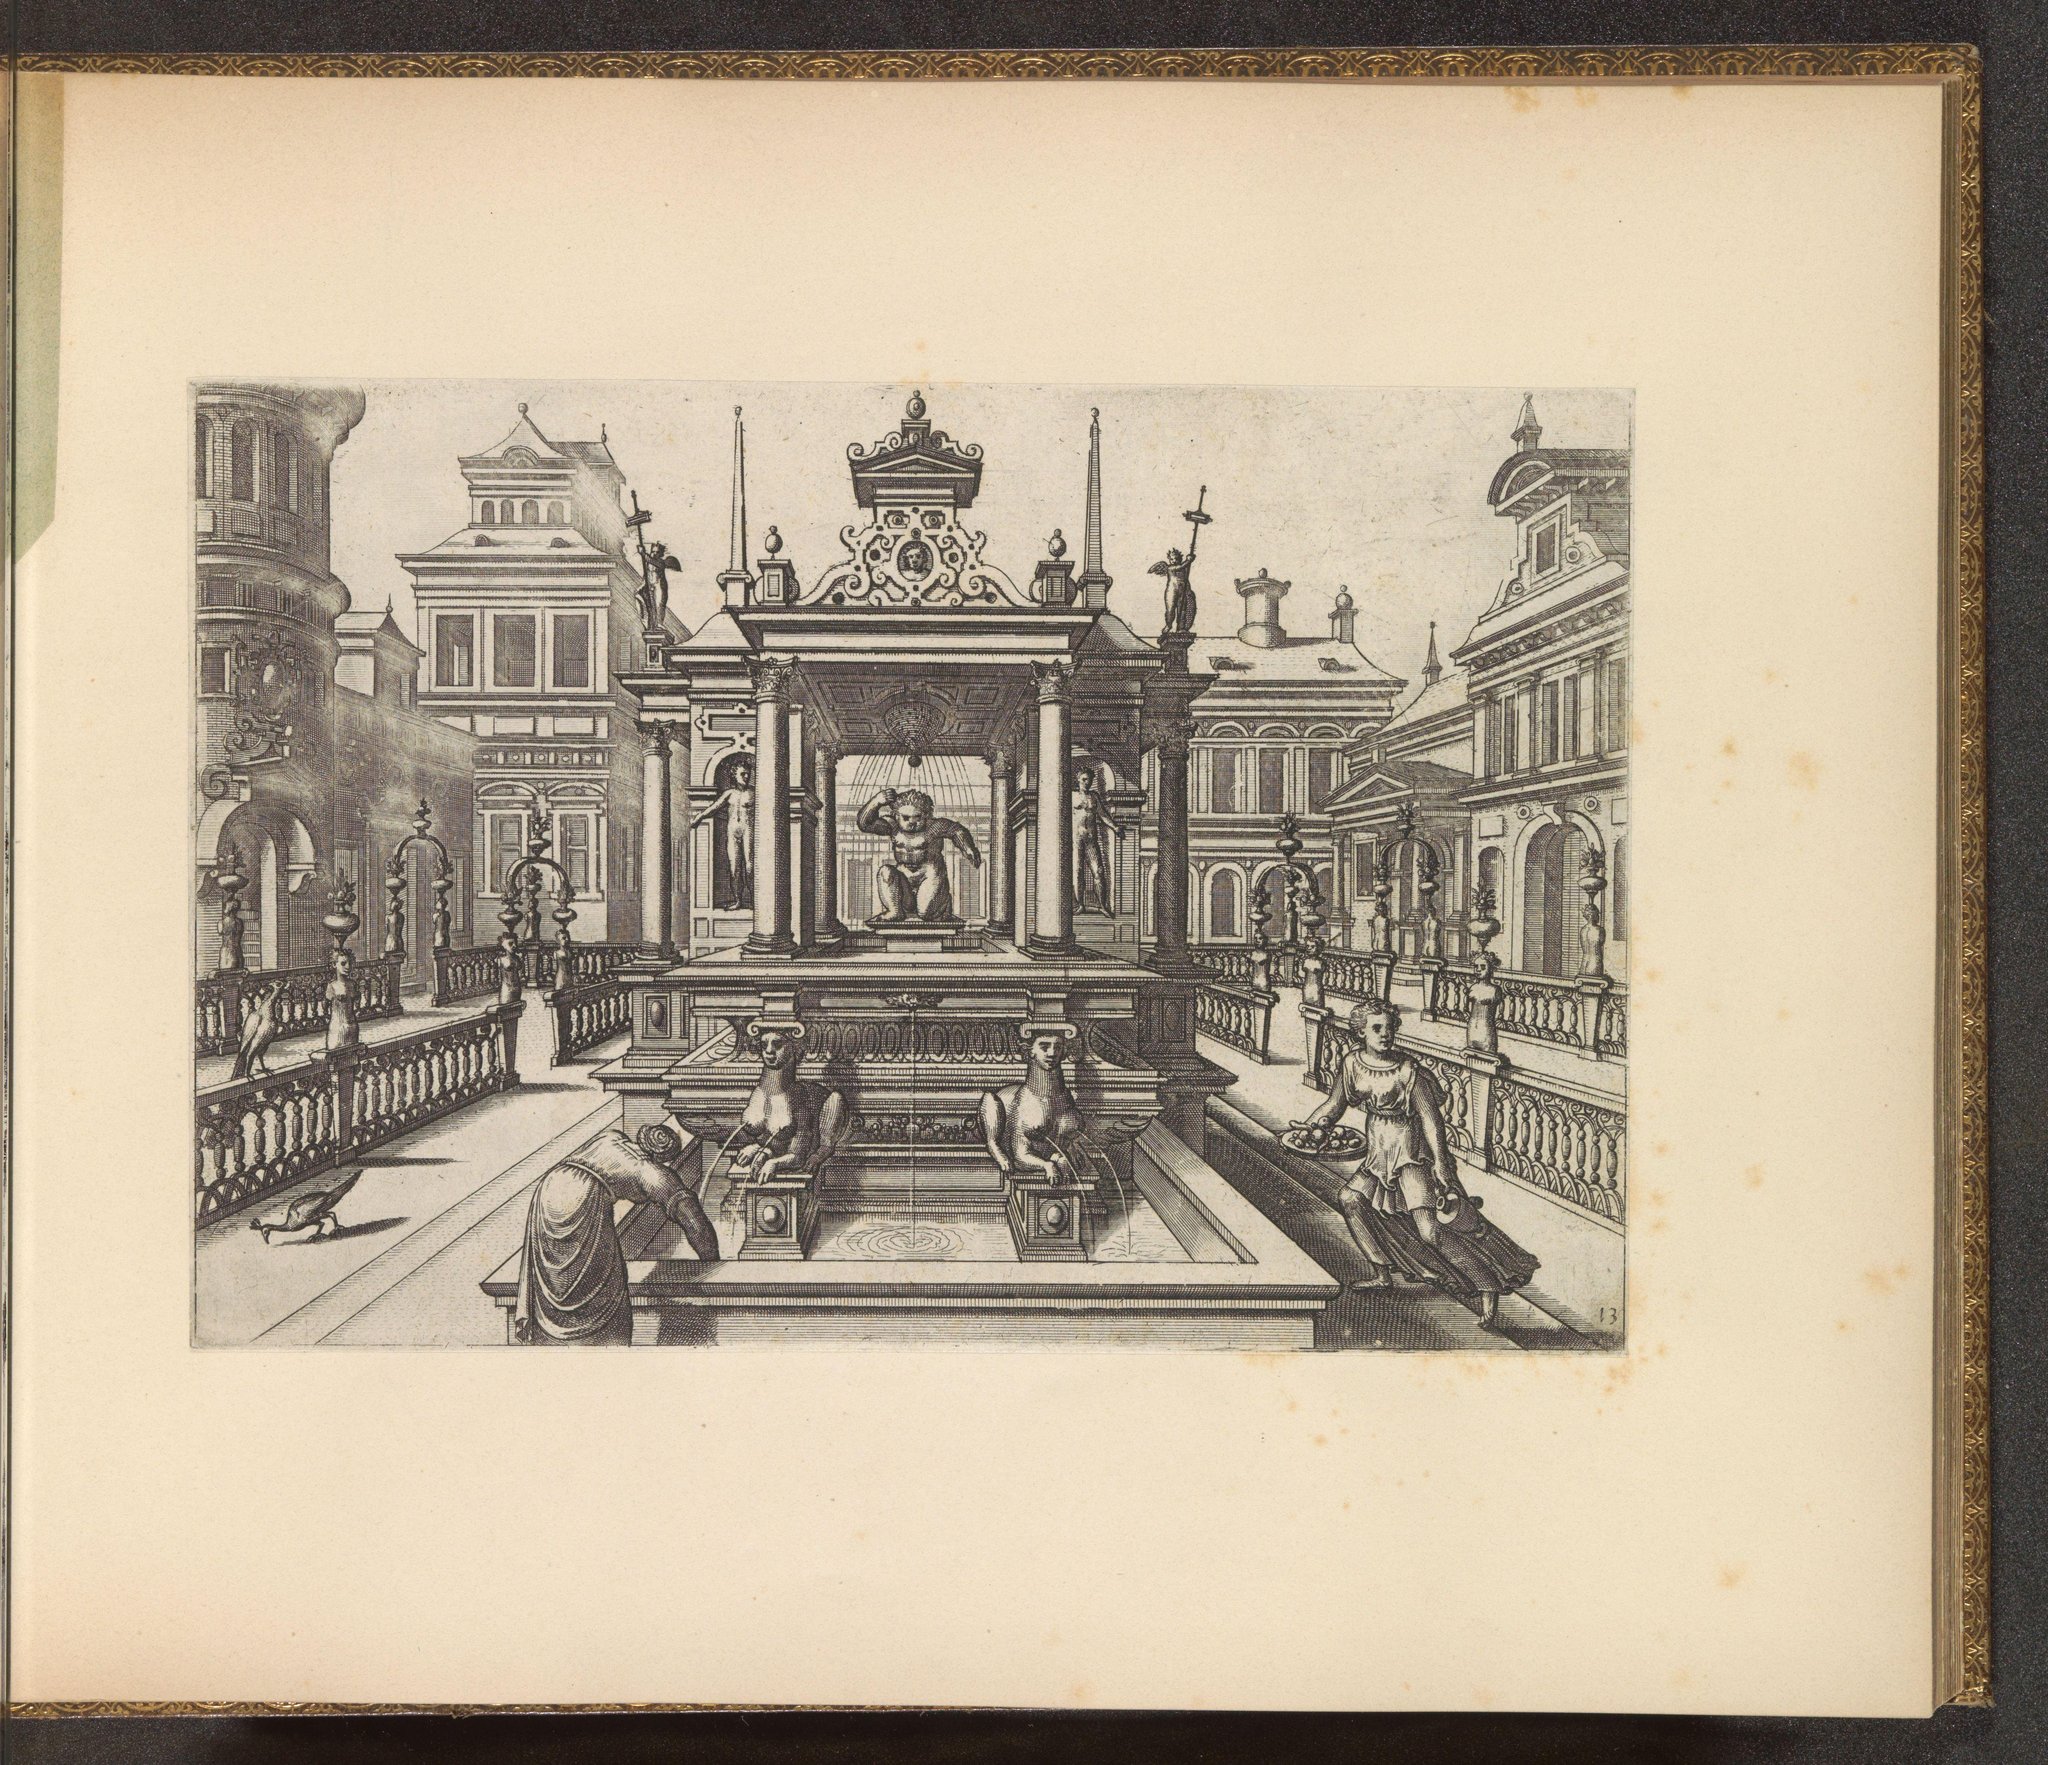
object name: album leaf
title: Artis Perspectiva (...)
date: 1600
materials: paper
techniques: etching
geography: antwerp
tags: sphinx (lion/woman); 'sfinge' (ripa), ornamental fountain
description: Plein met een fontein, omgeven door hekken met vrouwelijke hermen. Op een piedestal, waarvoor twee sfinxen liggen die spuiten in een lager gelegen bekken, staat een paviljoentje met zuilen van de Korinthische orde. Daarin zit een kind dat van boven wordt besproeid. Op de voorgrond scheept een vrouw water uit de fontein. De prent maakt deel uit van een album.